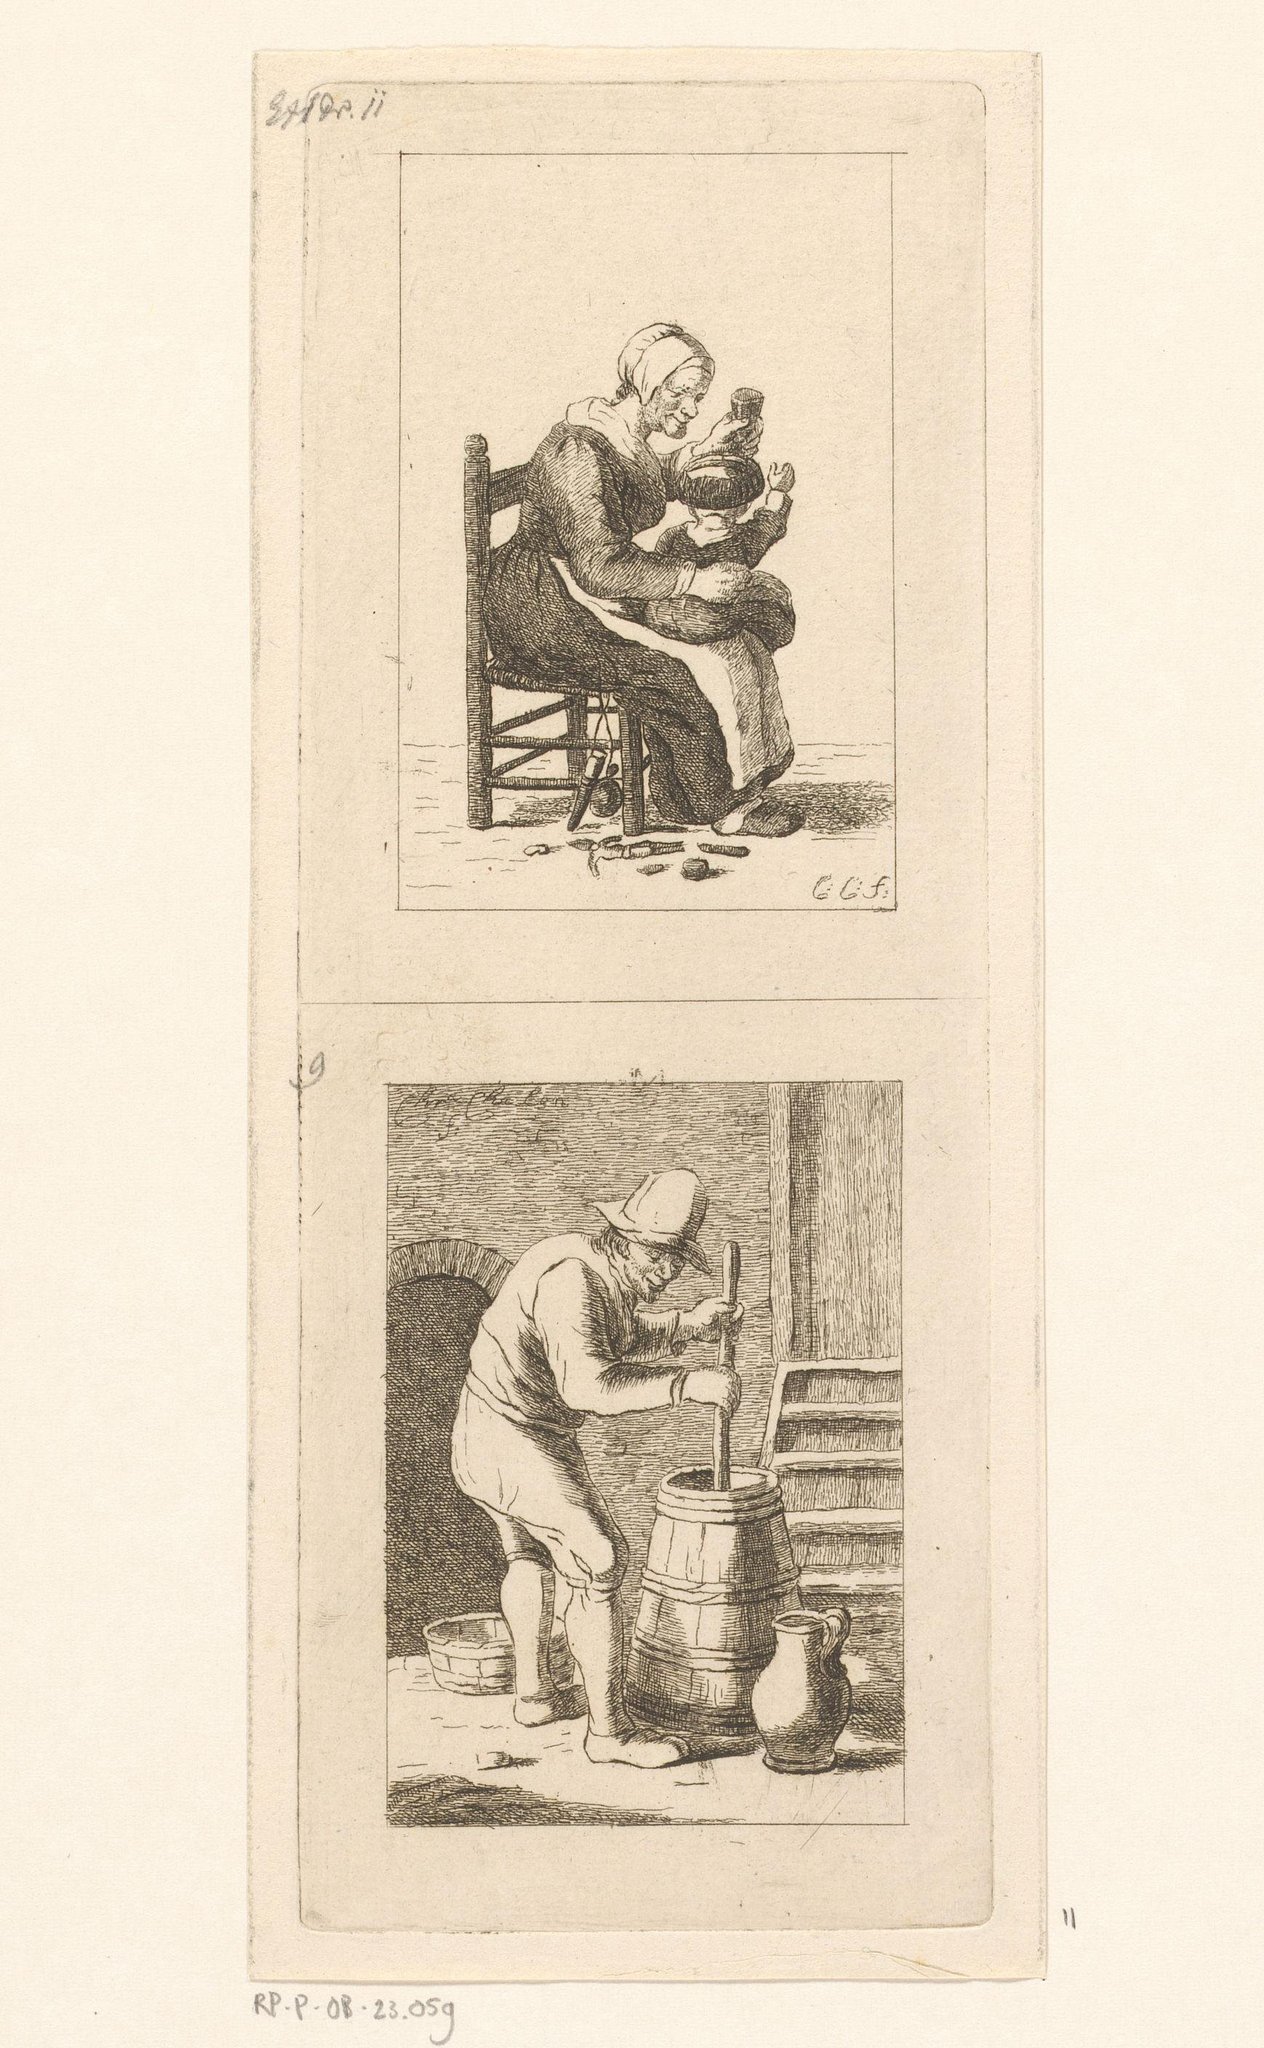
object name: print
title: Vrouw met kind op schoot en karnende man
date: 1779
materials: paper, pencil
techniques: etching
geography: leiden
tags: mother and baby or young child, churning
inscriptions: collector's mark: Lugt 240, number: ‘EtsPr. ii. 9.’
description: Twee voorstellingen: boven een zittende vrouw met een kind op schoot en onder een karnende man.